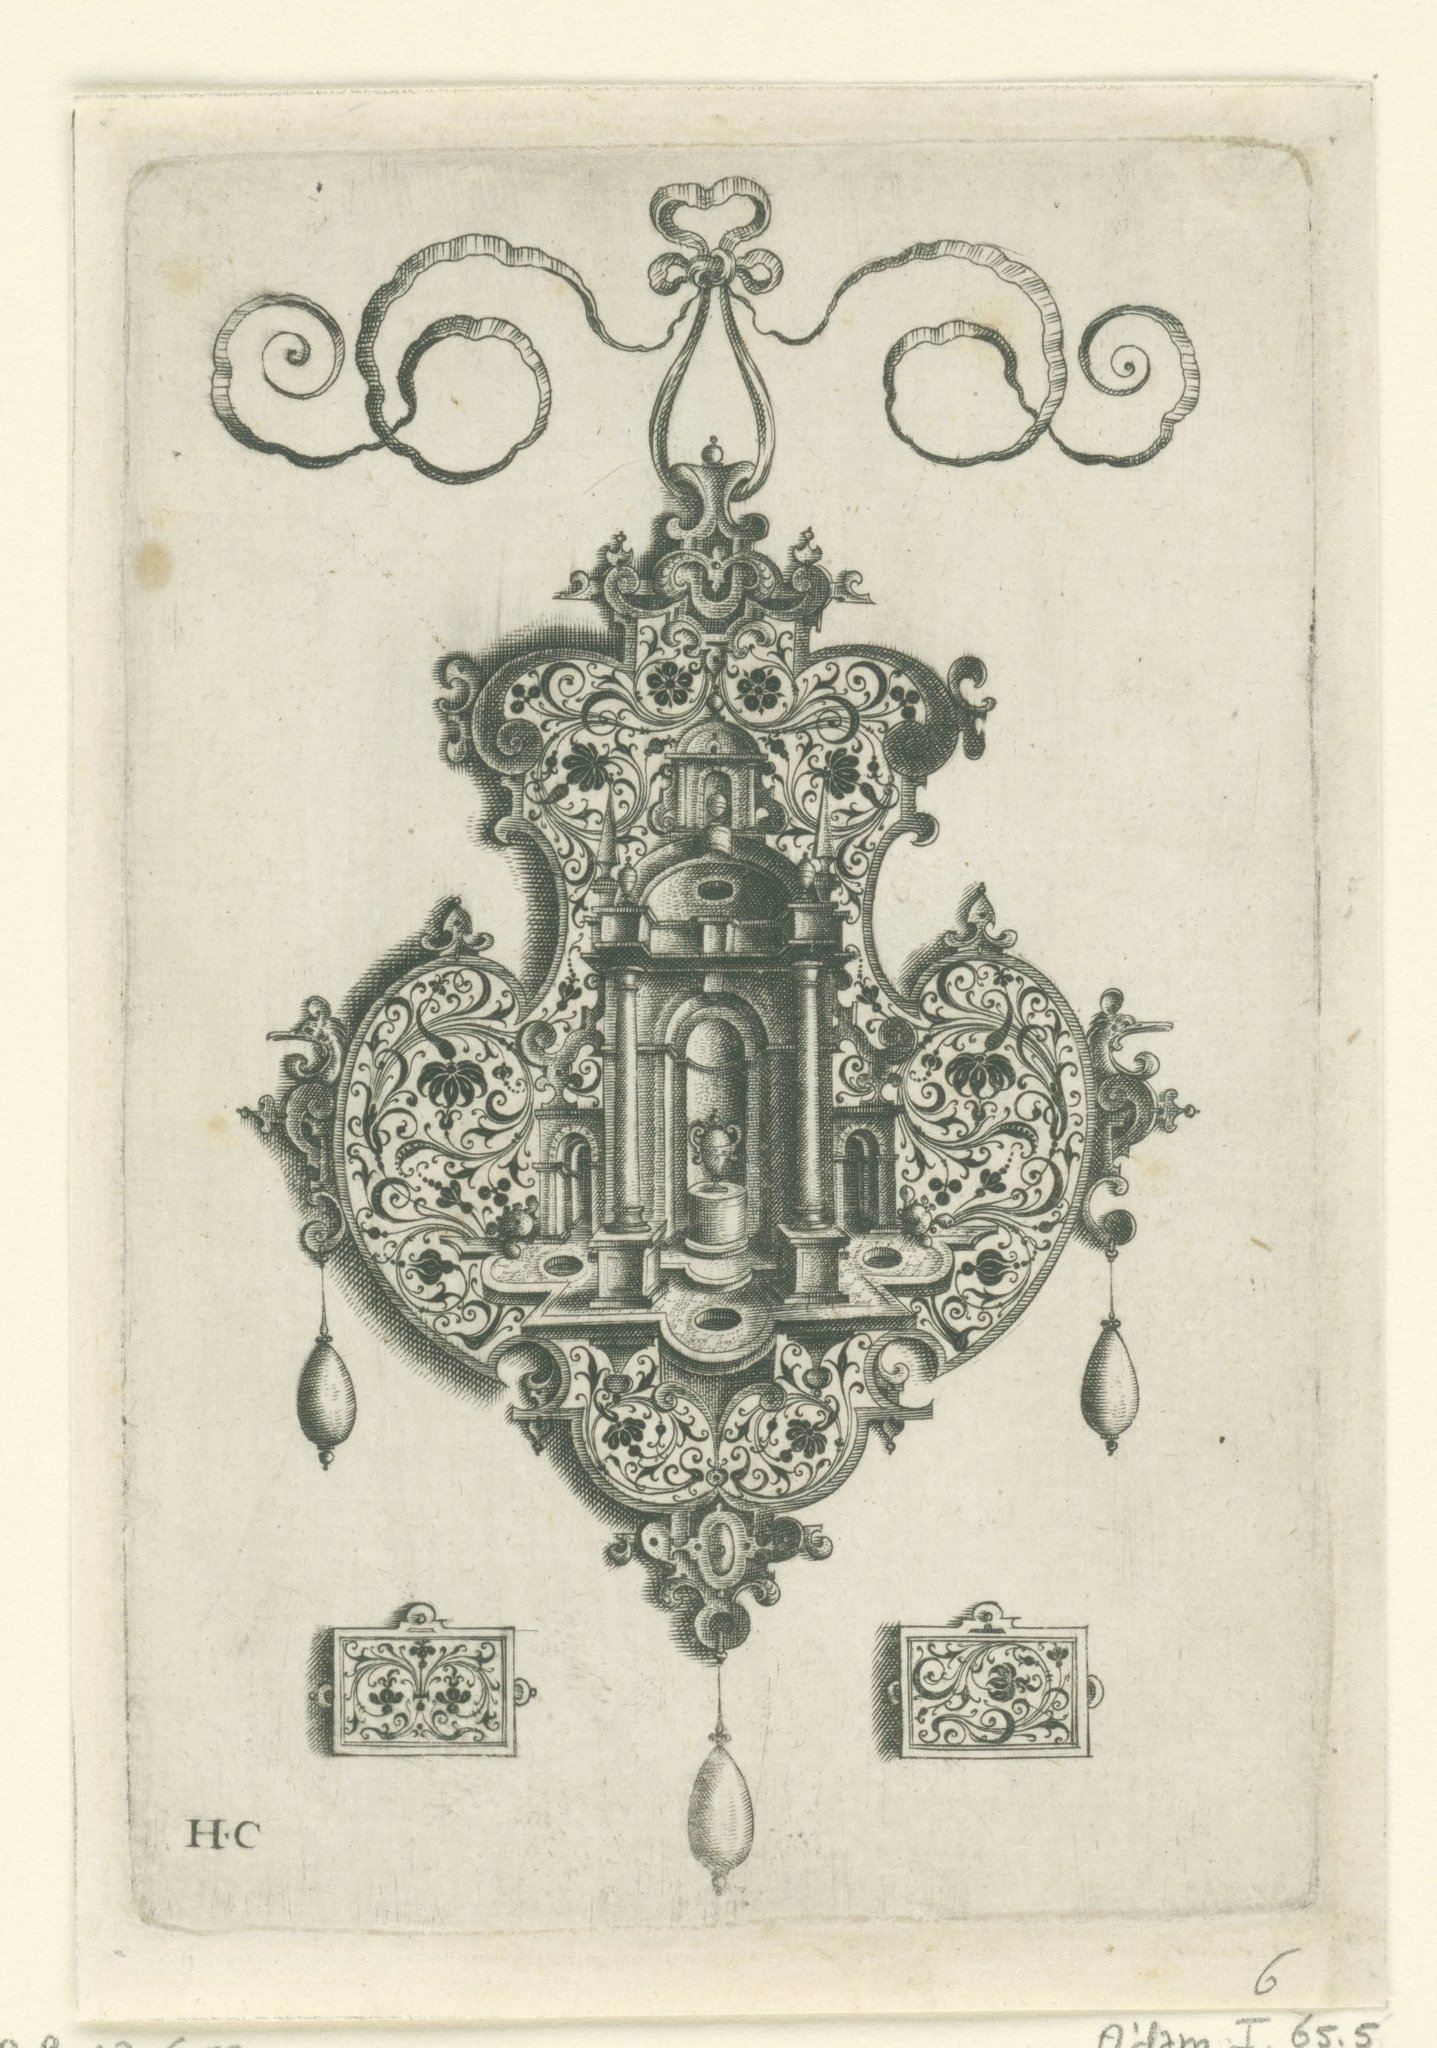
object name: print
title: Voorzijde hanger: nis met koepel en zijbeuken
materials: paper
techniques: engraving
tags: pendant, trinket, 'breloque'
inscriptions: monogram: ‘HC’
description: Voorzijde van een hanger met in het midden een nis met koepeltje en zijbeuken. In de nis staat een vaas met oren op een verhoging. Linksonder en rechtsonder een rechthoekig kostuumornament. Een van 9 bladen afkomstig uit een serie van 10 bladen met hangers. Aan iedere hanger hangen drie parels. Op elk blad bovendien nog twee of vier kleine kostuumornamenten.